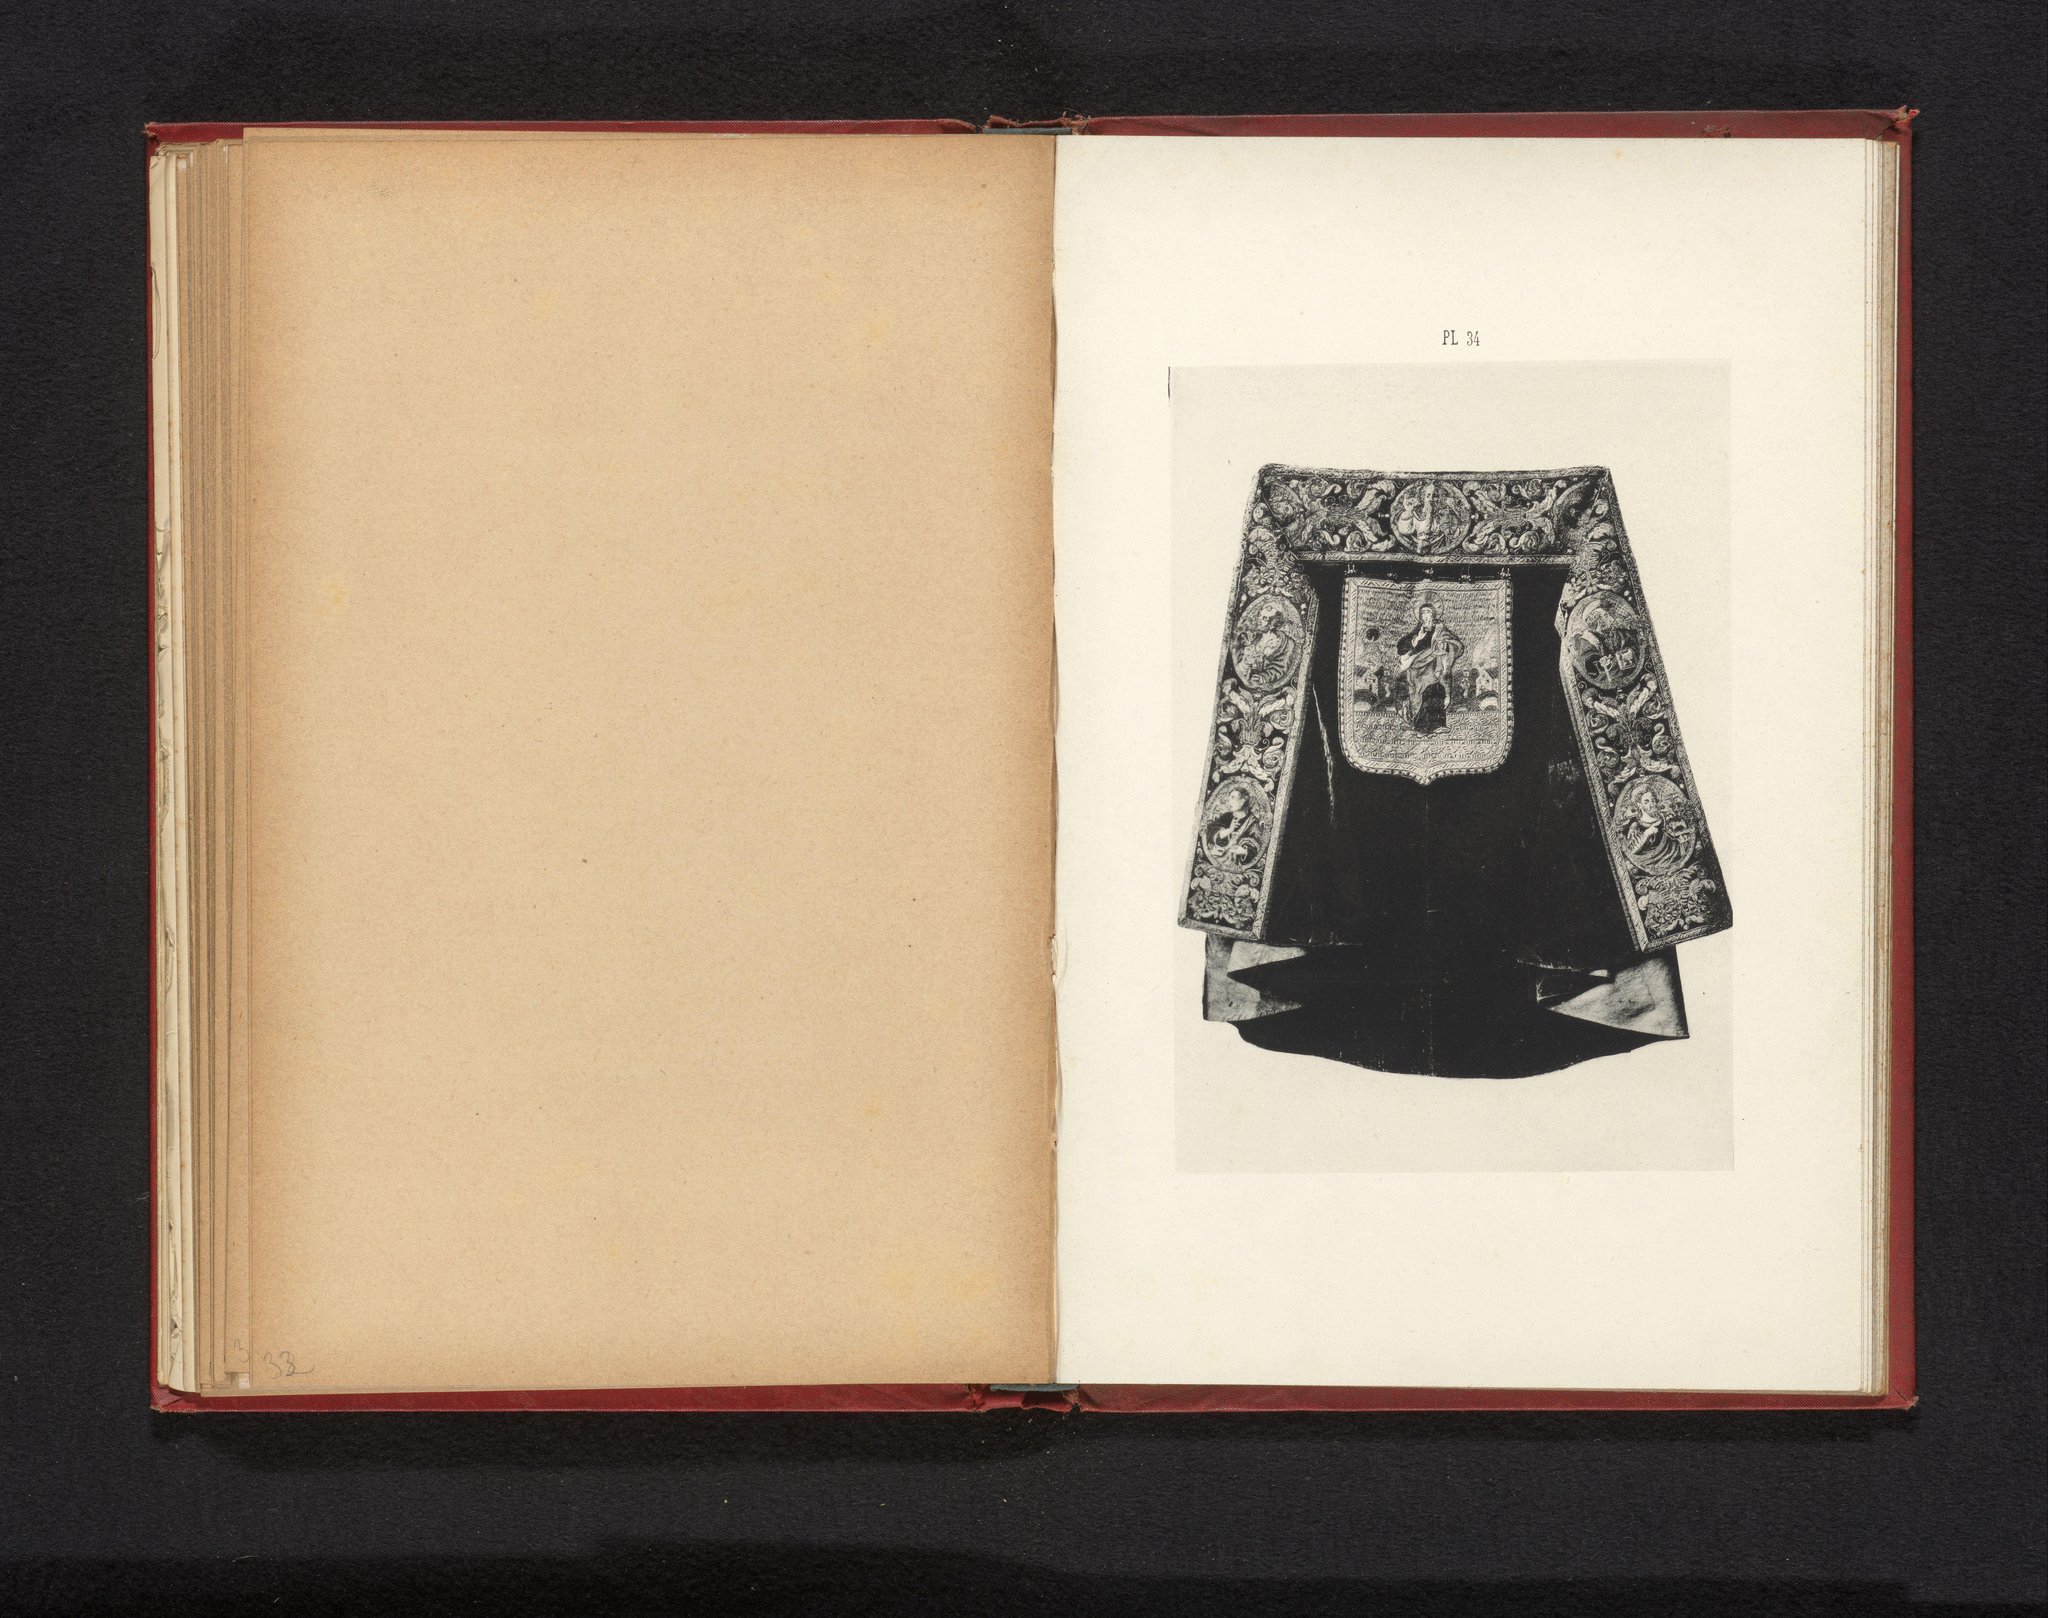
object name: photomechanical print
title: Kazuifel met een afbeelding van de Madonna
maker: Anonymous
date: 1880-1881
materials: paper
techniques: photograph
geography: barcelona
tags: madonna: i.e. mary with the christ-child, chasuble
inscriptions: number: ‘Pl 34’